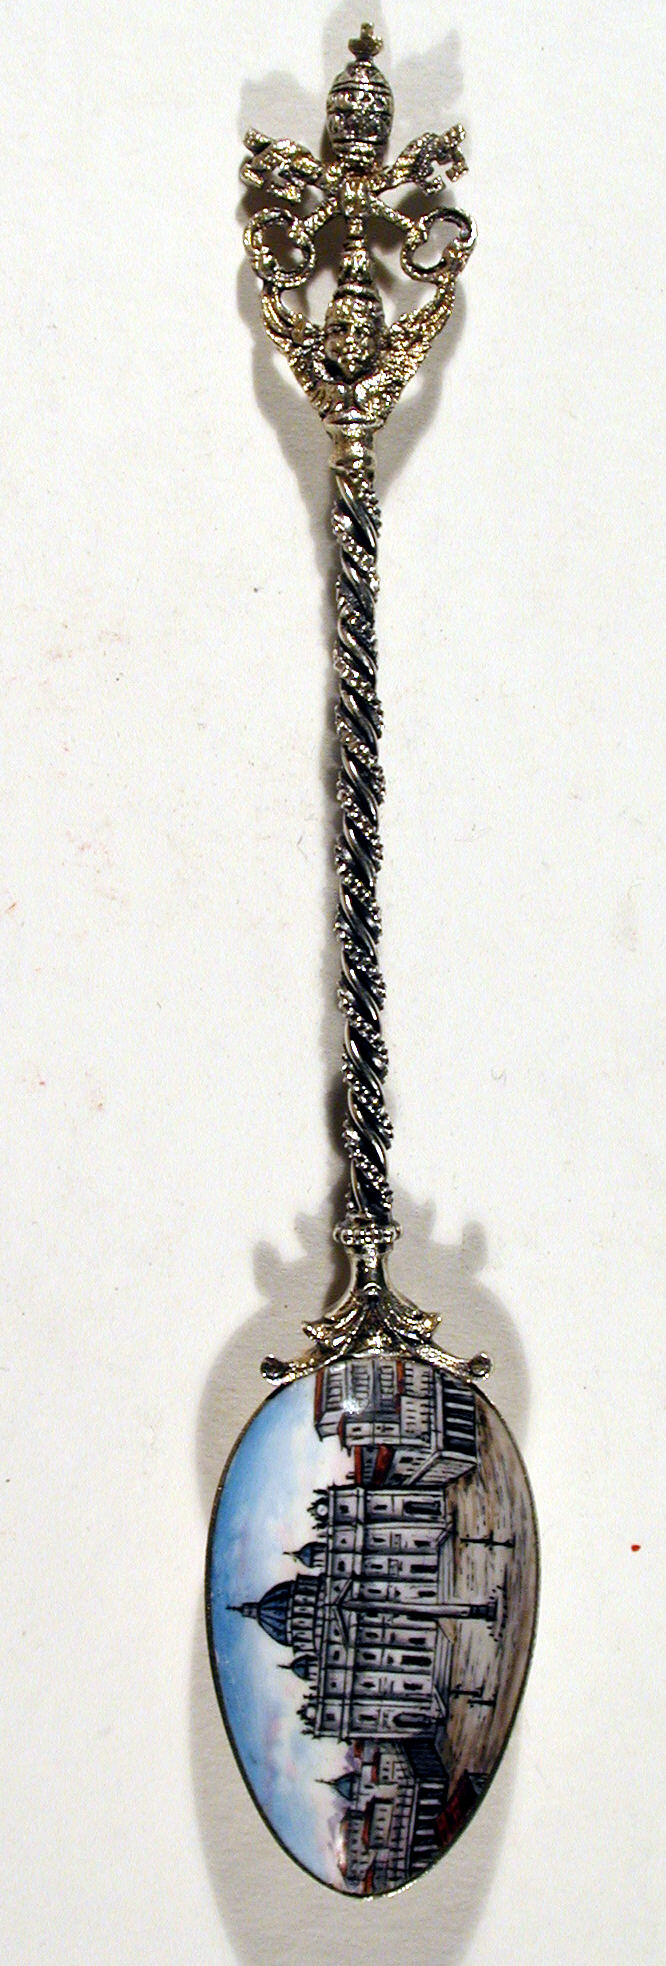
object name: souvenir spoon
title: Souvenir spoon with view of St. Peter's Square and St. Peter's Basilica, Rome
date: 1867-1900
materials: enamel, gilt, silver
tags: churches